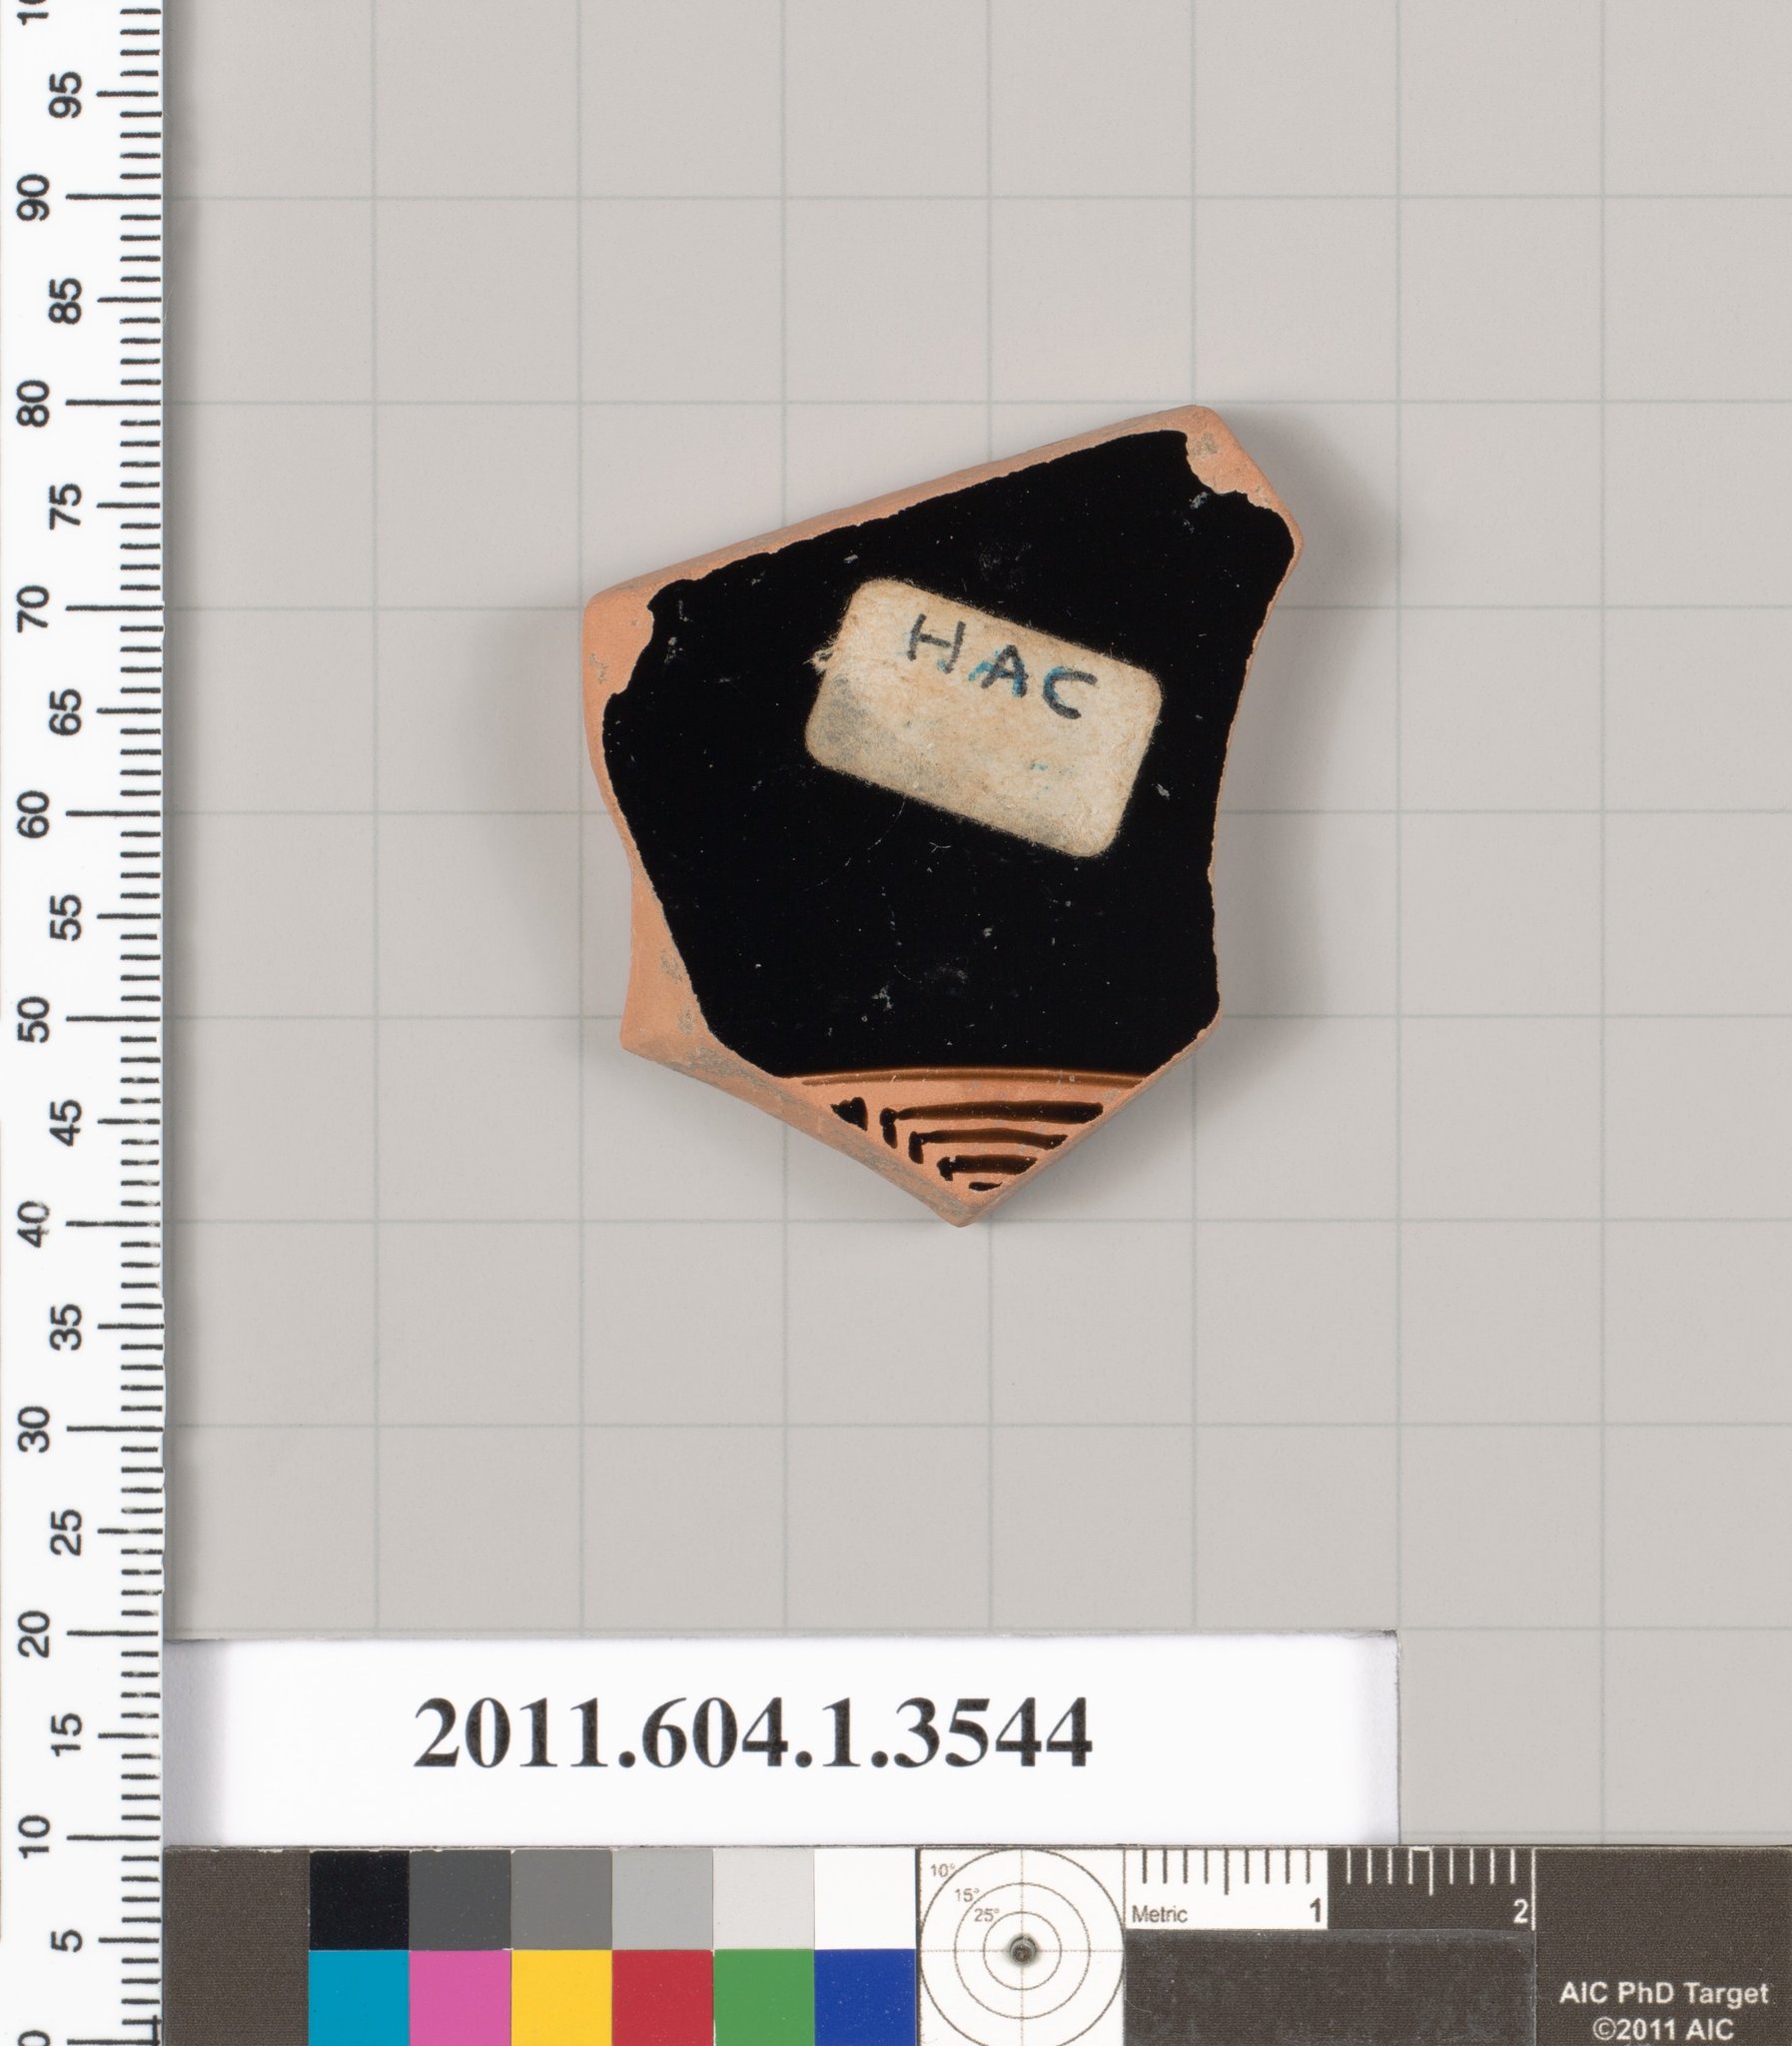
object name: kylix fragment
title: Terracotta fragment of a kylix (drinking cup)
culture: greek, attic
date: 500-476 BCE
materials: terracotta